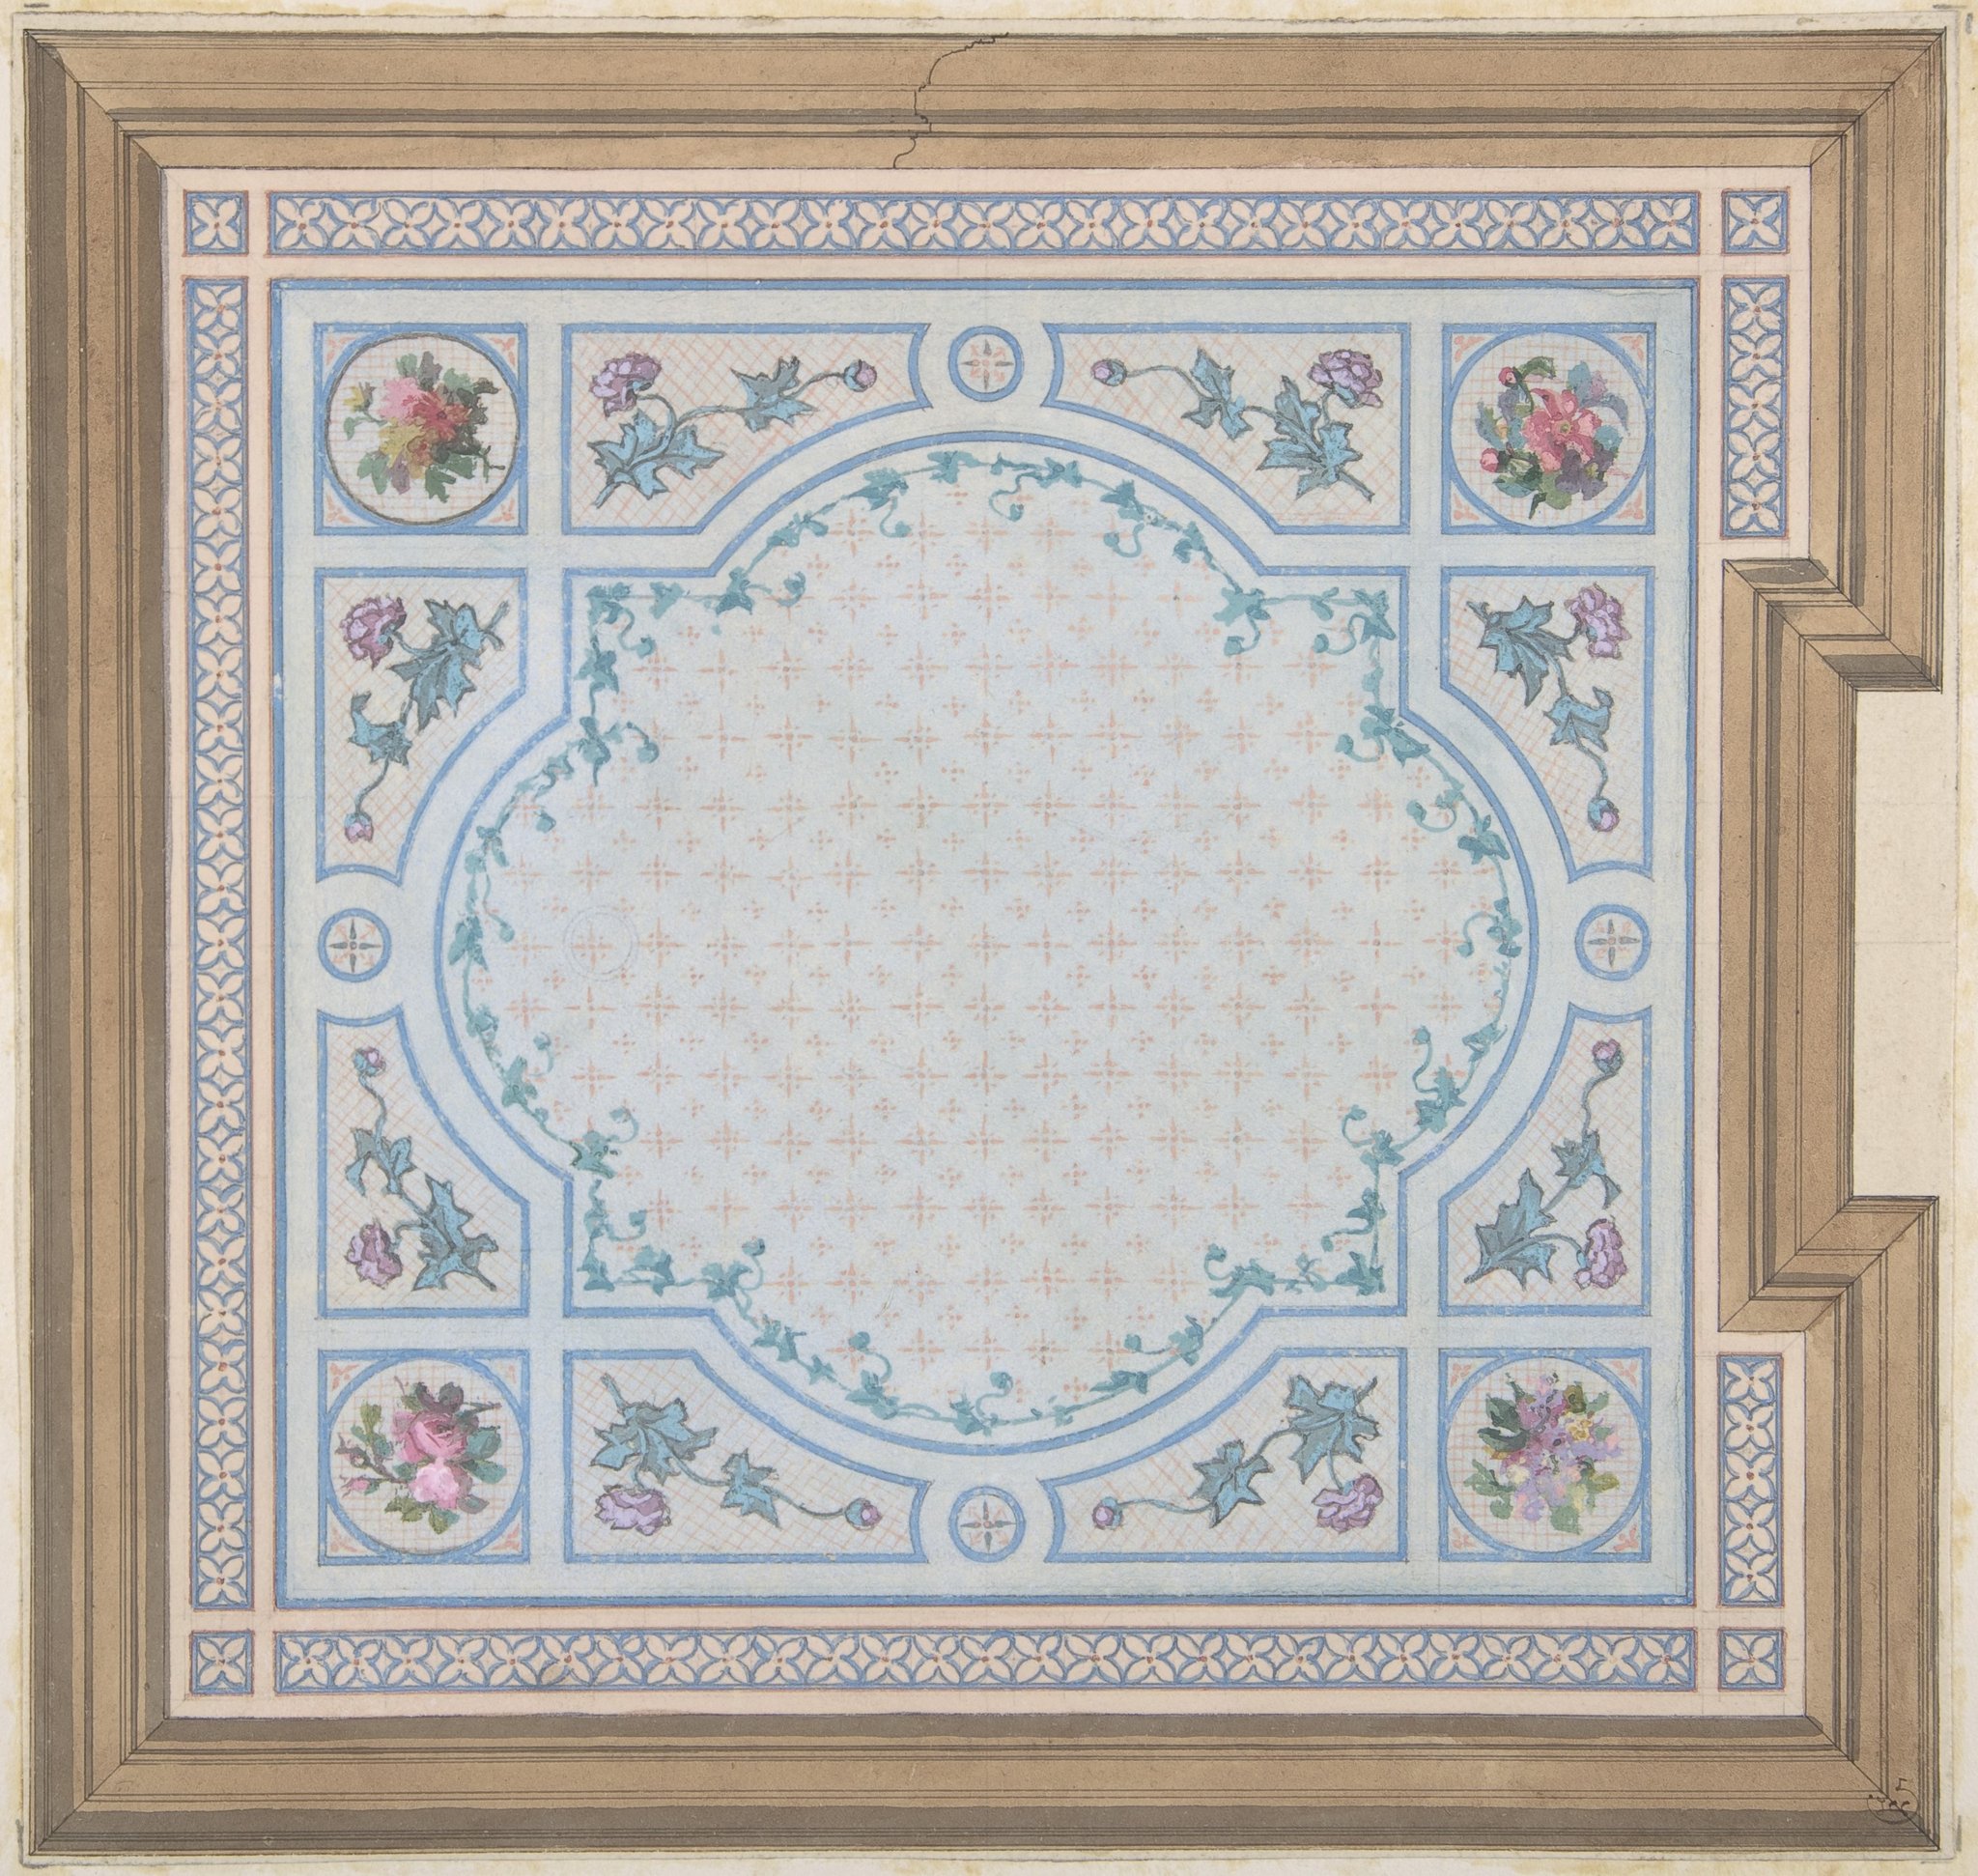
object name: drawing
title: Design for Bathroom Ceiling, Hôtel Cahen d'Anvers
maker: jules-edmond-charles lachaise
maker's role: artist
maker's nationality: french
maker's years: 1897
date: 1851-1900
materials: ink, watercolor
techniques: pen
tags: ceilings